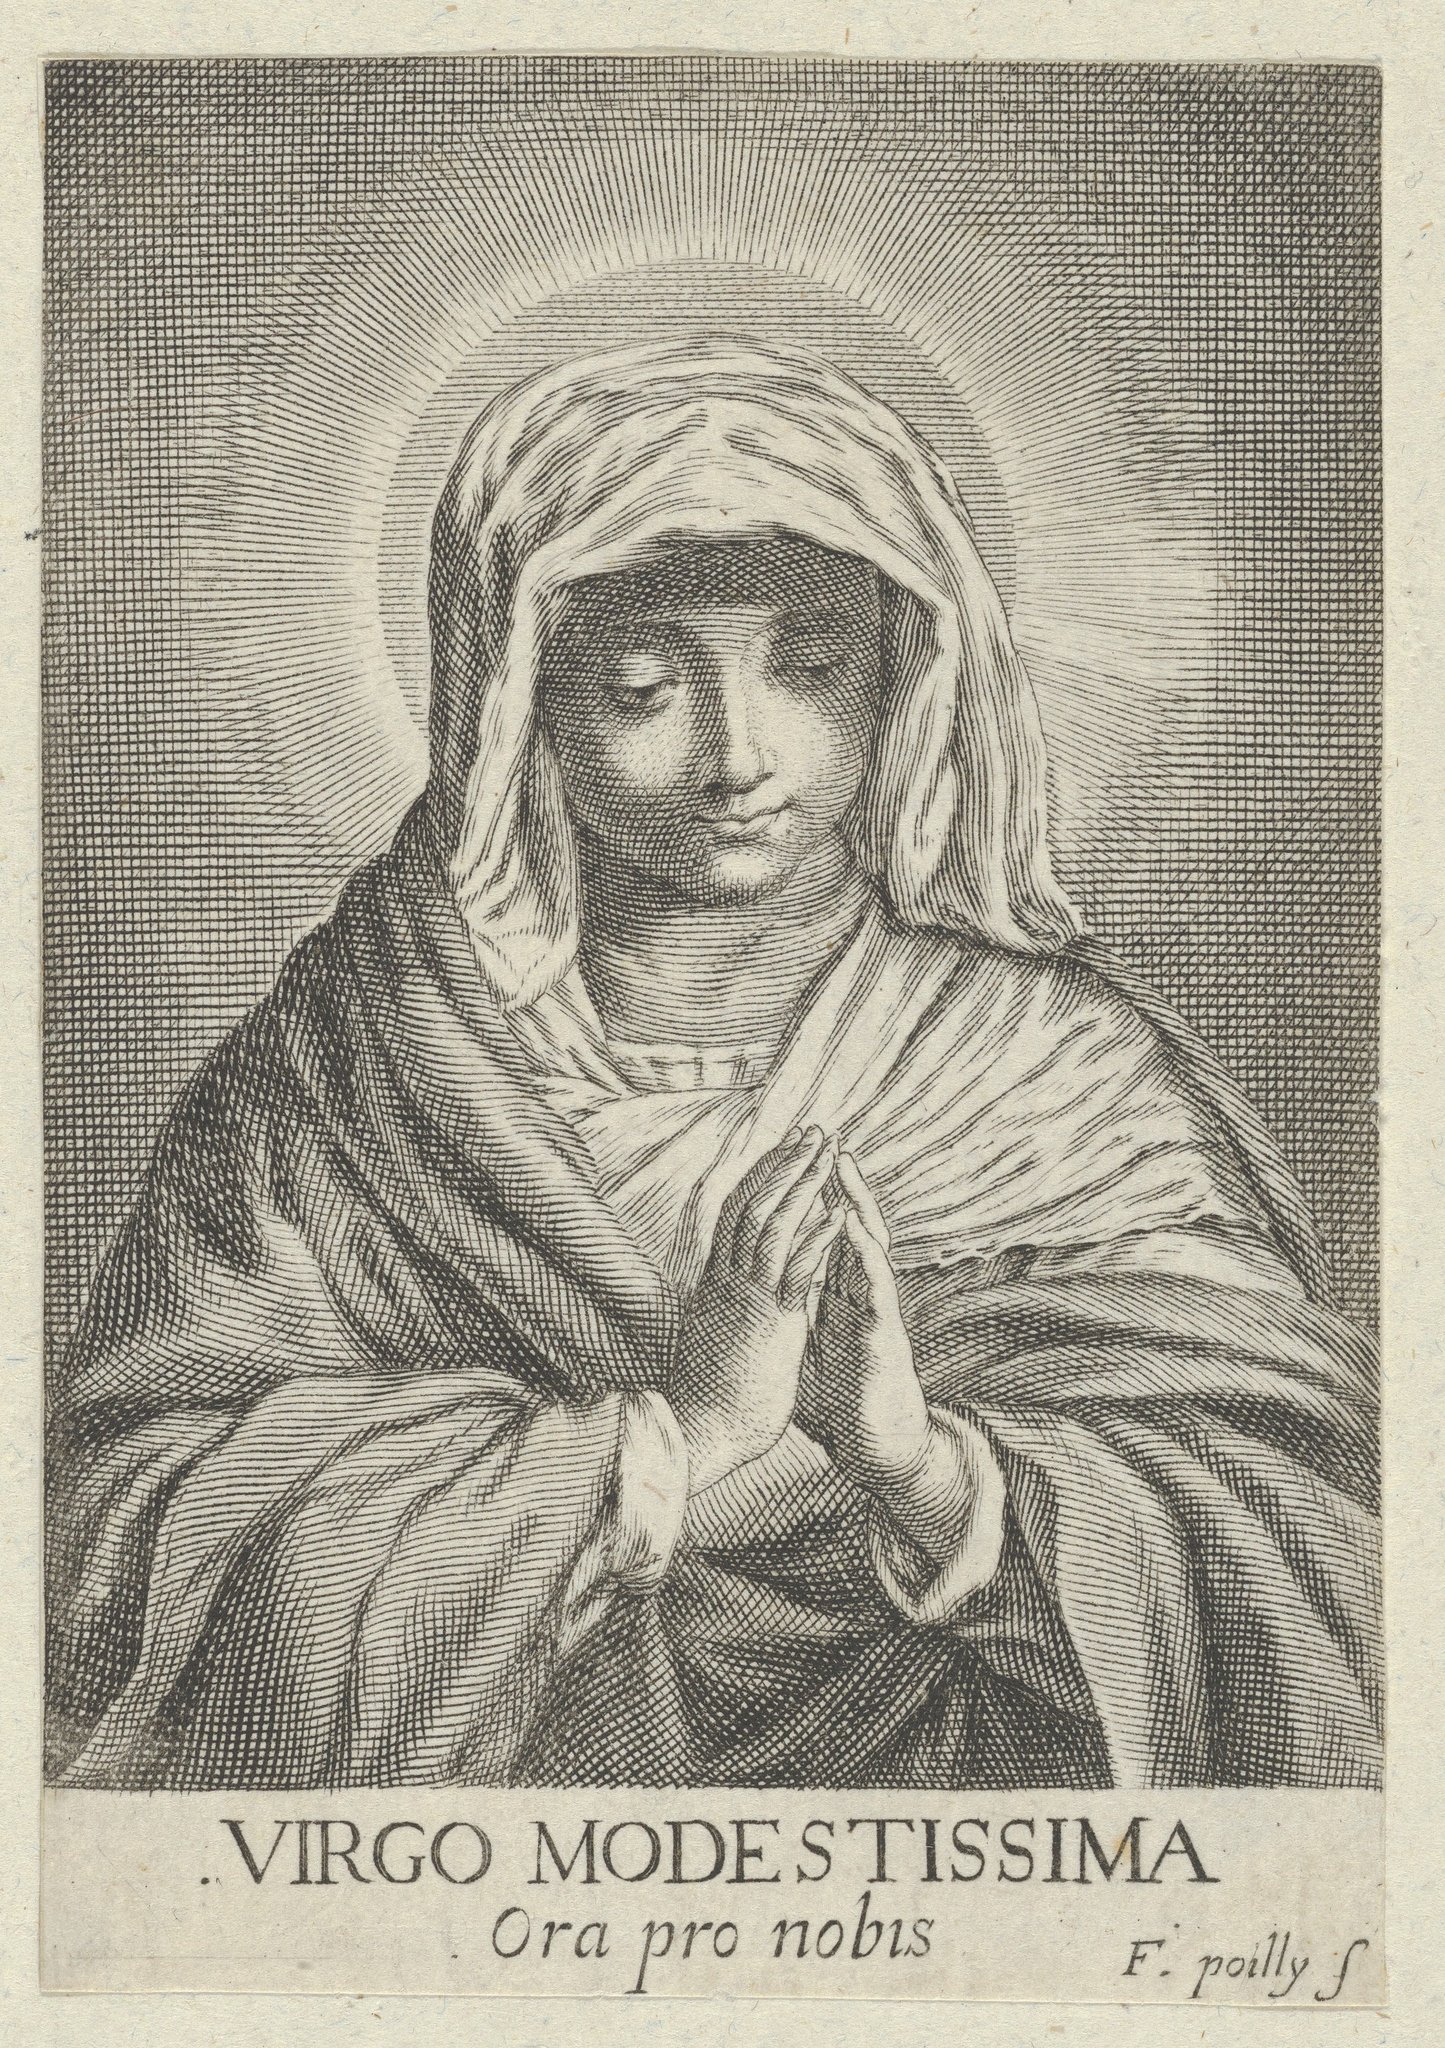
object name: print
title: The Virgin in prayer looking down, after Reni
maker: francois de poilly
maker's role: artist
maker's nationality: french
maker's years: 1623-1693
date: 1640-1693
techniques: engraving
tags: virgin mary